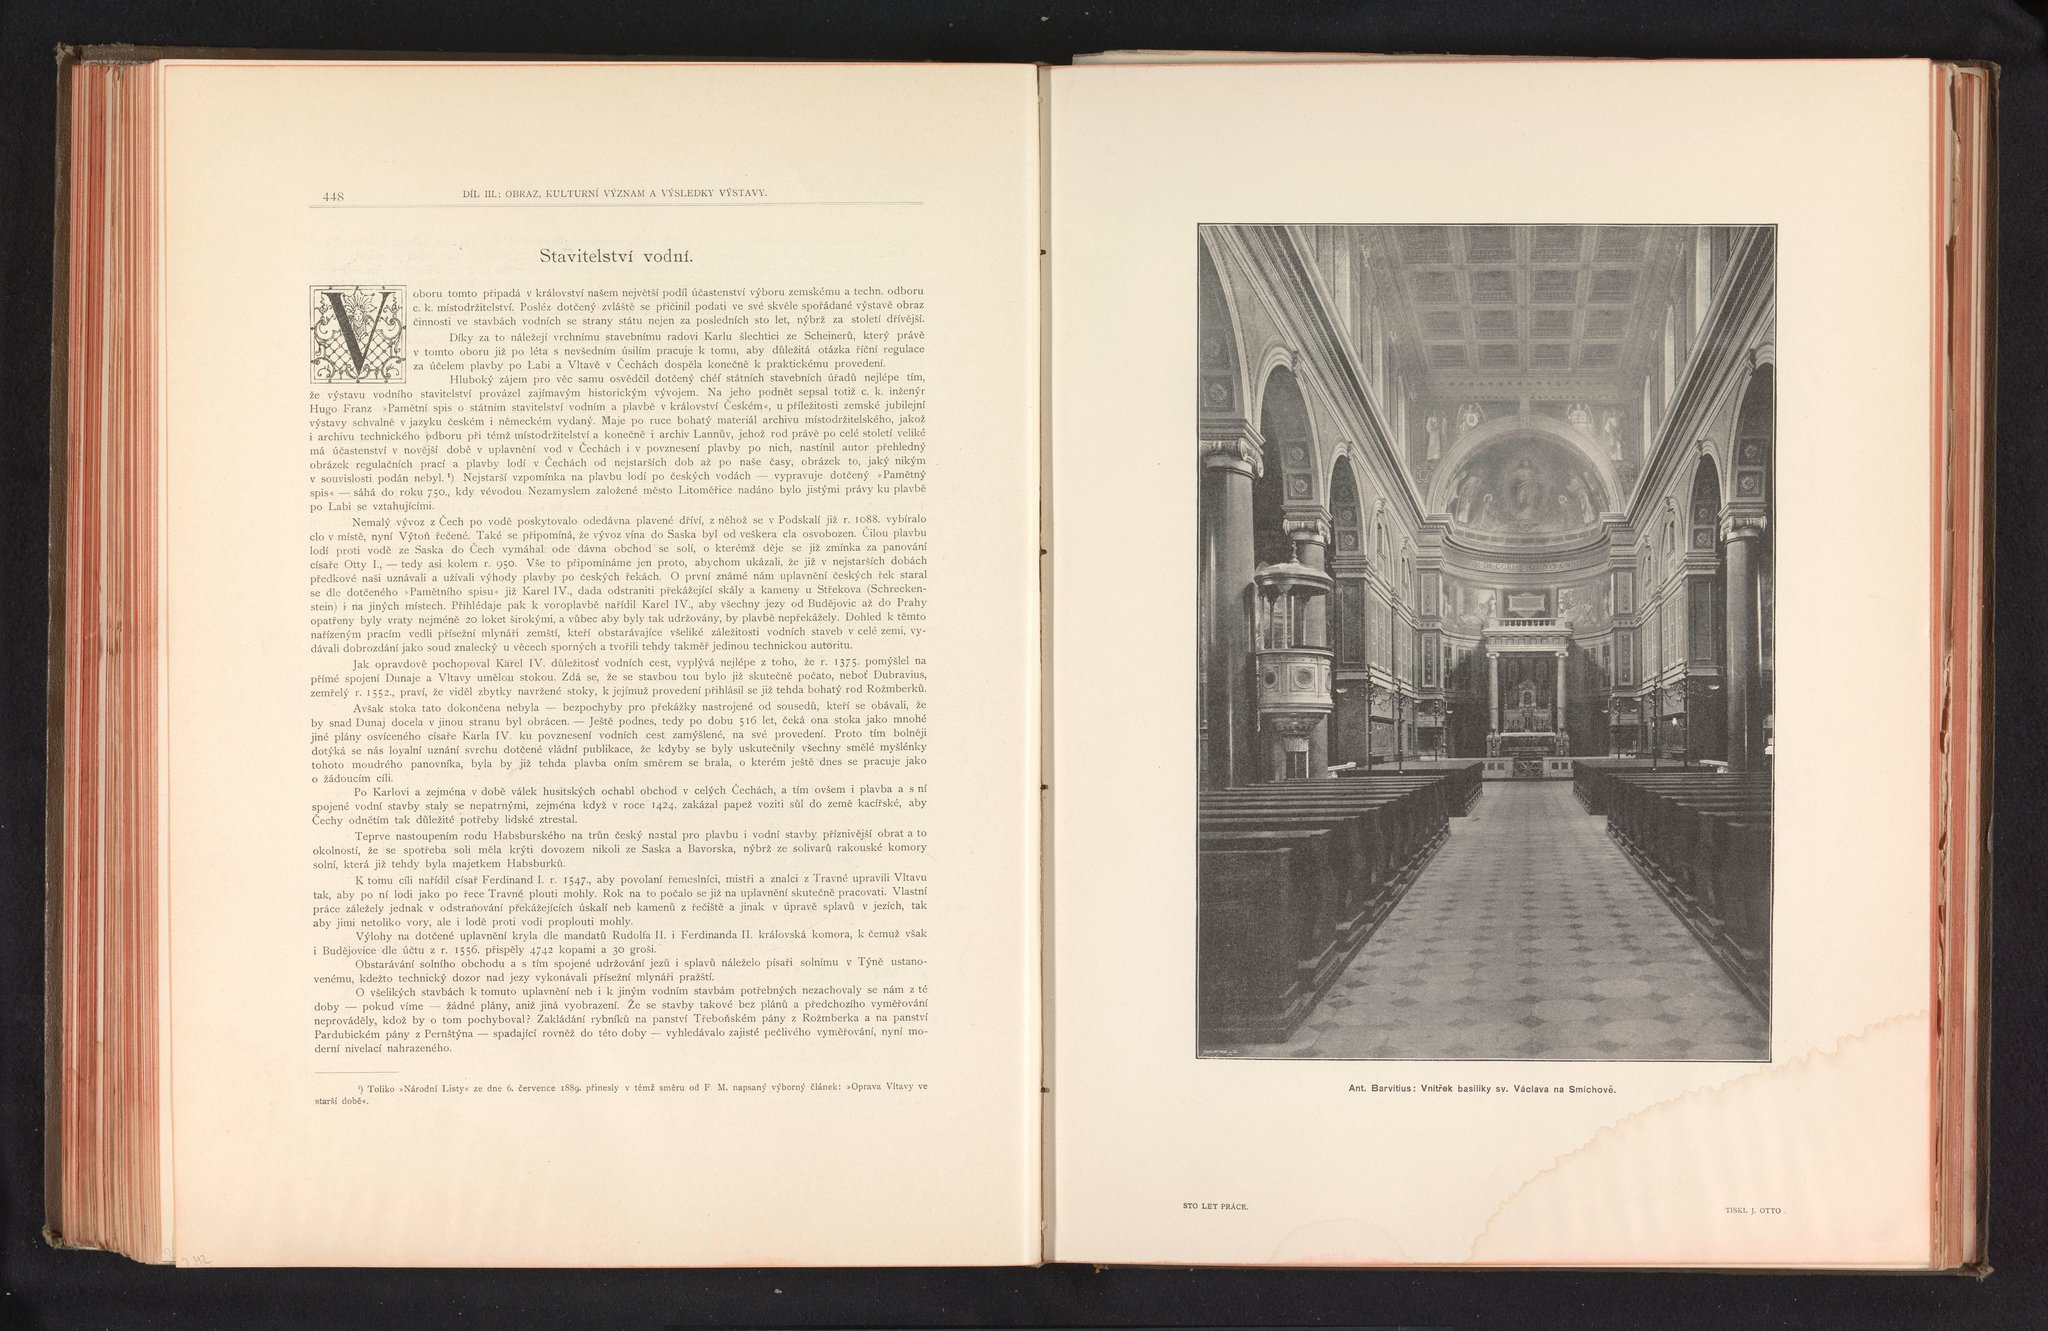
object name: page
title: Interieur van de Sint-Wenceslauskerk te Praag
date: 1891-1895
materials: paper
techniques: autotype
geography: sint-wenceslauskerk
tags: parts of church interior: aisle